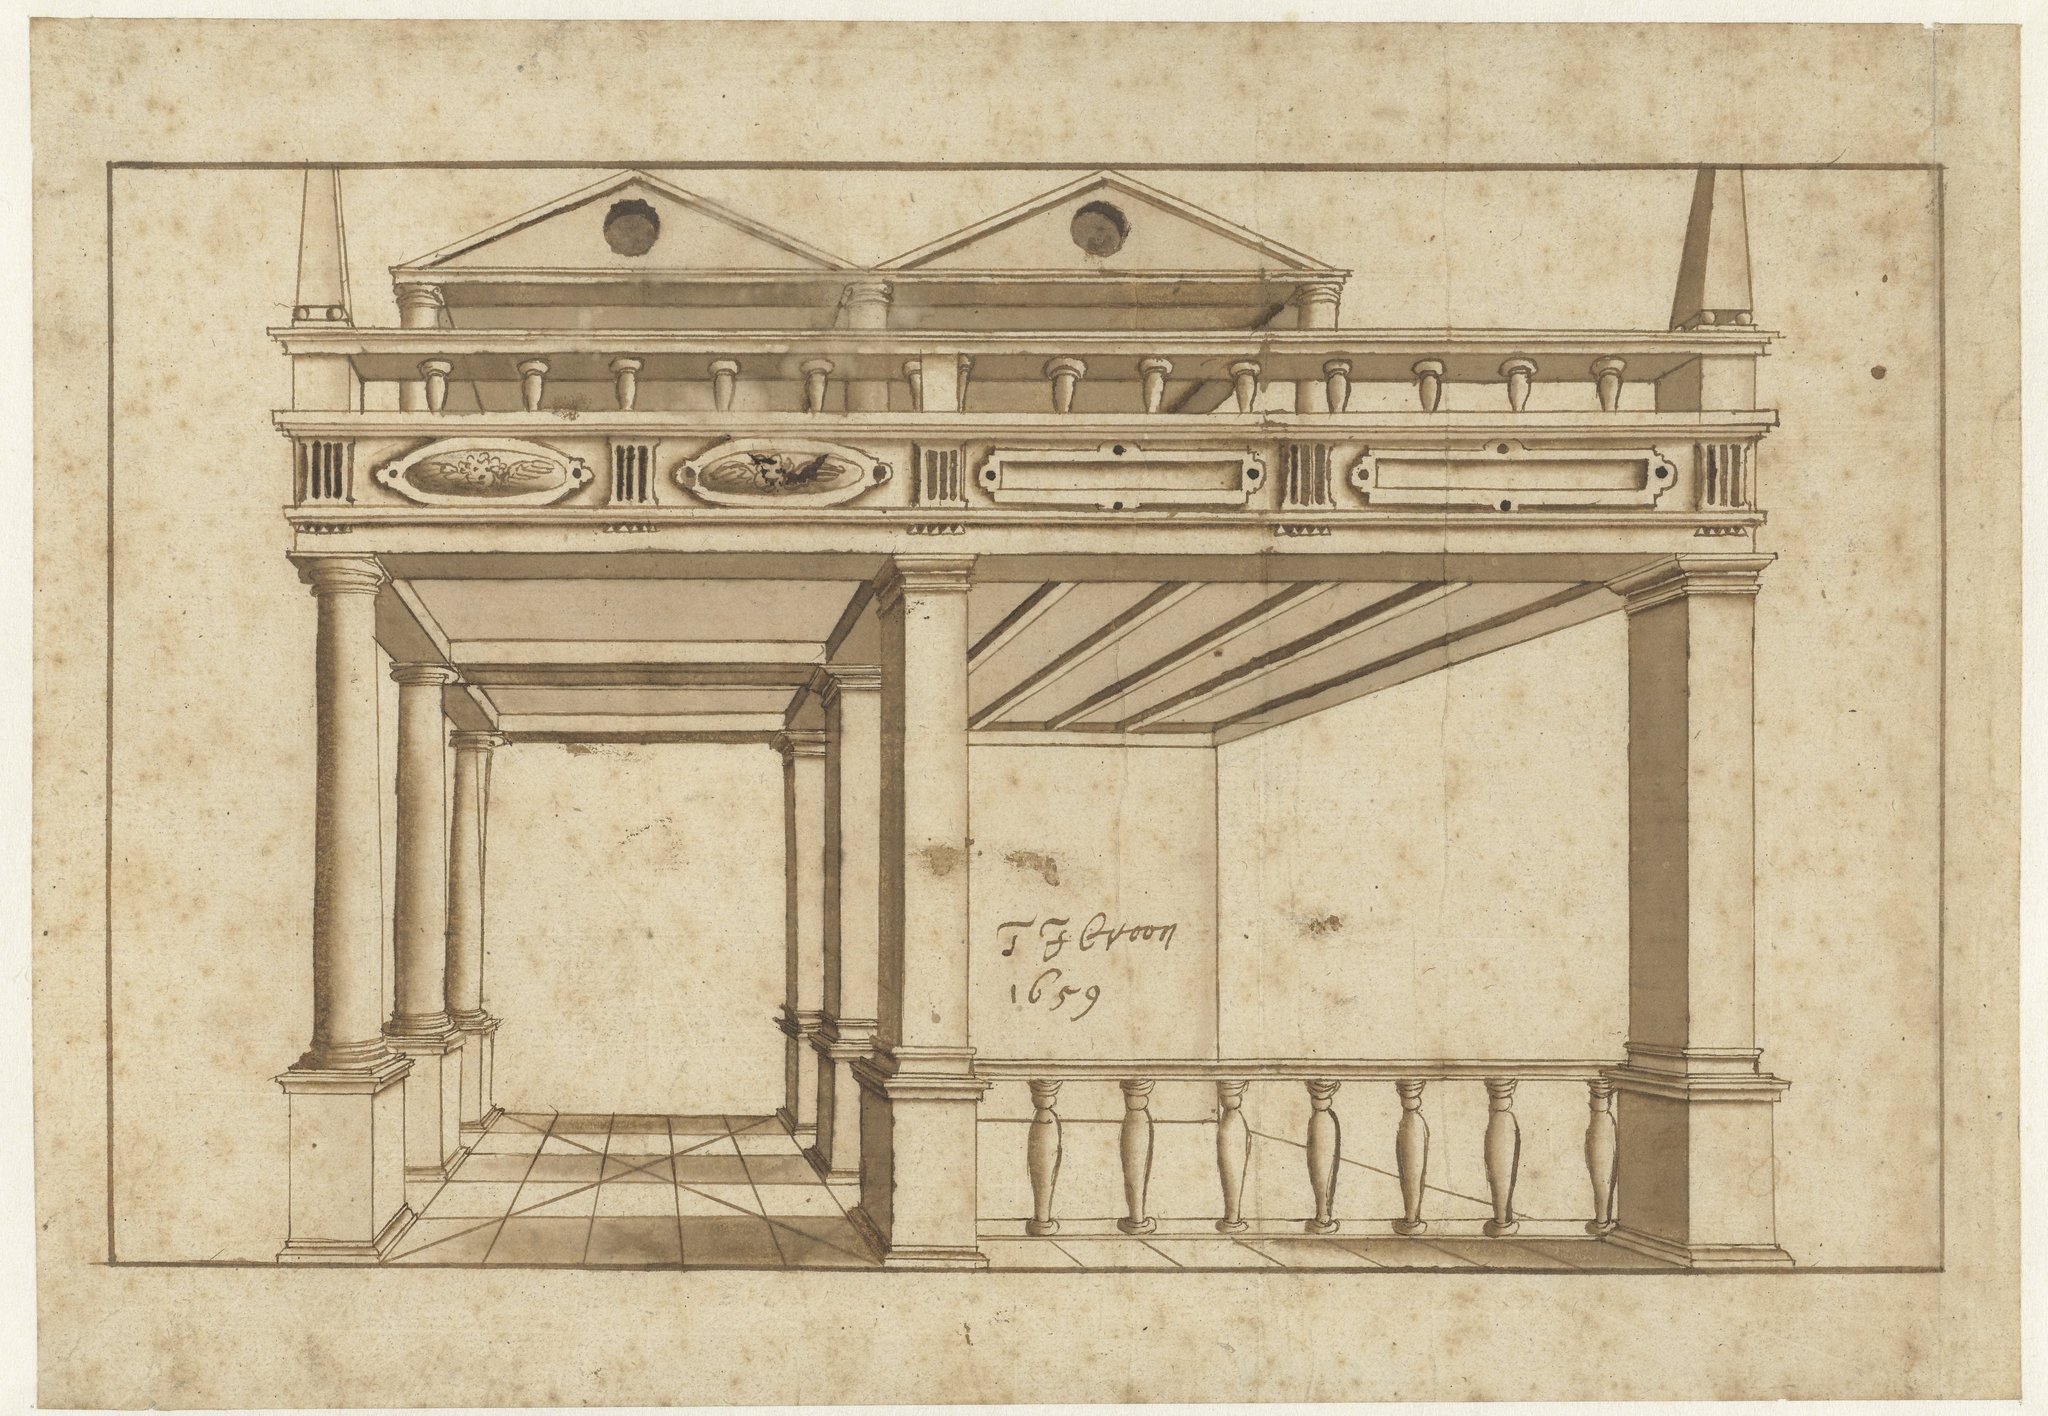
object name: architectuurtekening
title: Constructietekening in perspectivisch doorzicht van een gallerij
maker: teunis jansz croon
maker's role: draughtsman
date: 1659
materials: ink, paper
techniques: brush, pen